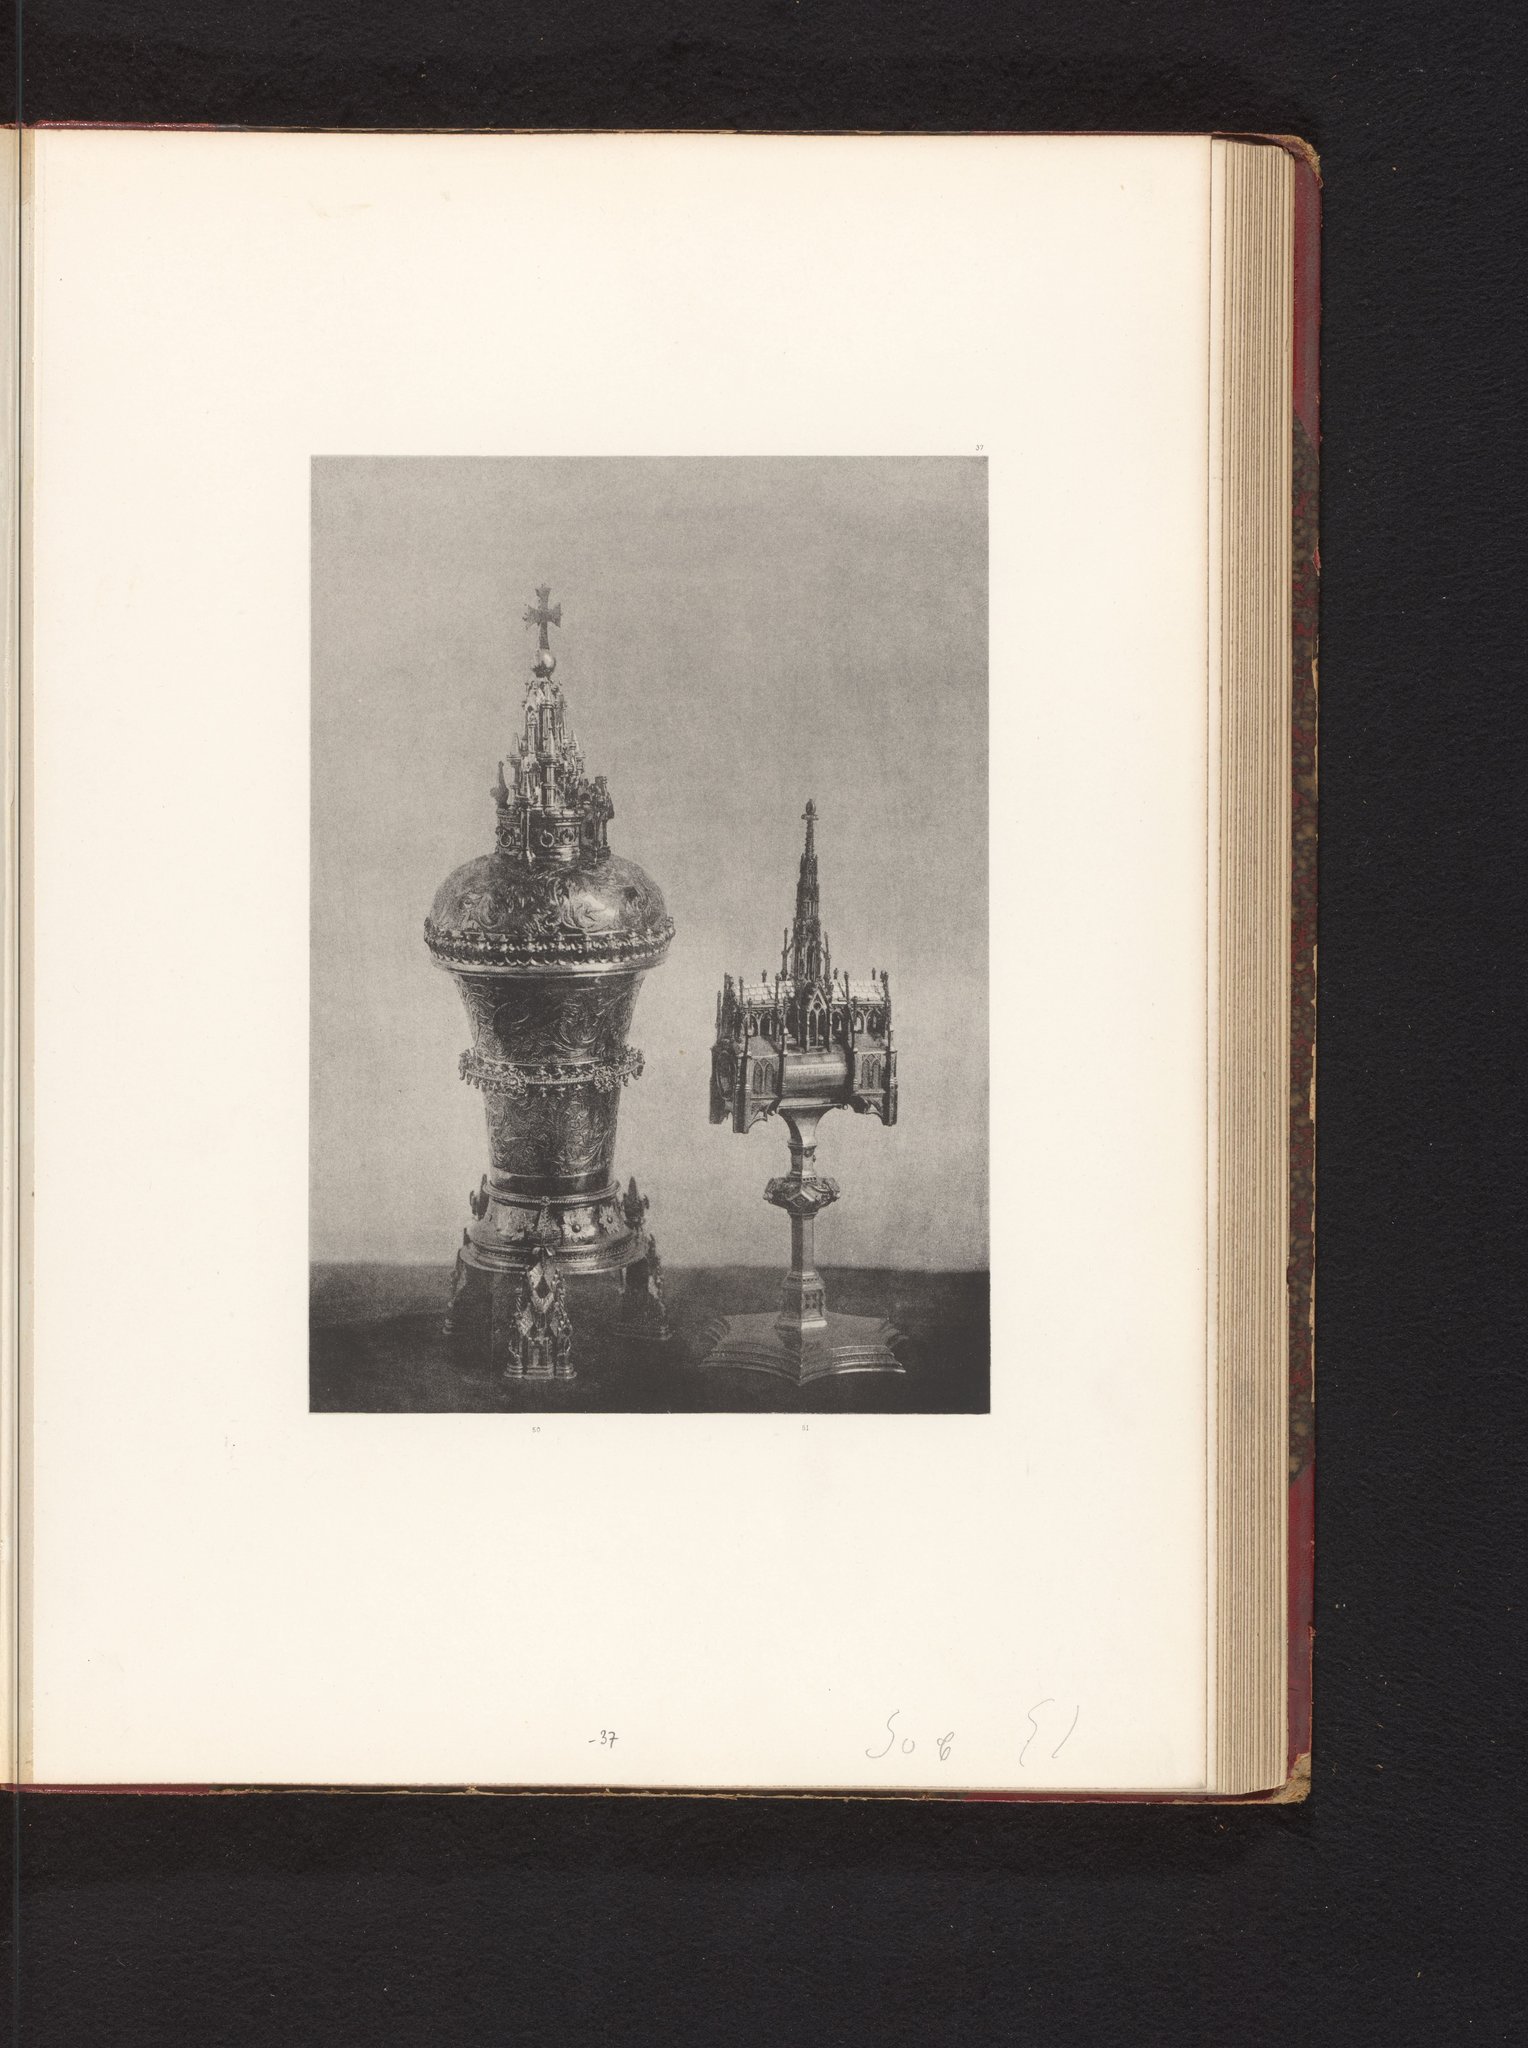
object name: page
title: Vergulde zilveren vaas en een monstrans, opgesteld op een tentoonstelling over religieuze objecten uit de middeleeuwen en renaissance in 1864 in Mechelen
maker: joseph maes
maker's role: fotograaf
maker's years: 1838-1908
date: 1864-1866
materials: paper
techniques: photolithography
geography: antwerp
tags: vessels and utensils used in the church, relics (and reliquaries), mechelen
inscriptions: number: ‘50 [.] 51’, number: ‘50 - 51’, number: ‘-37’